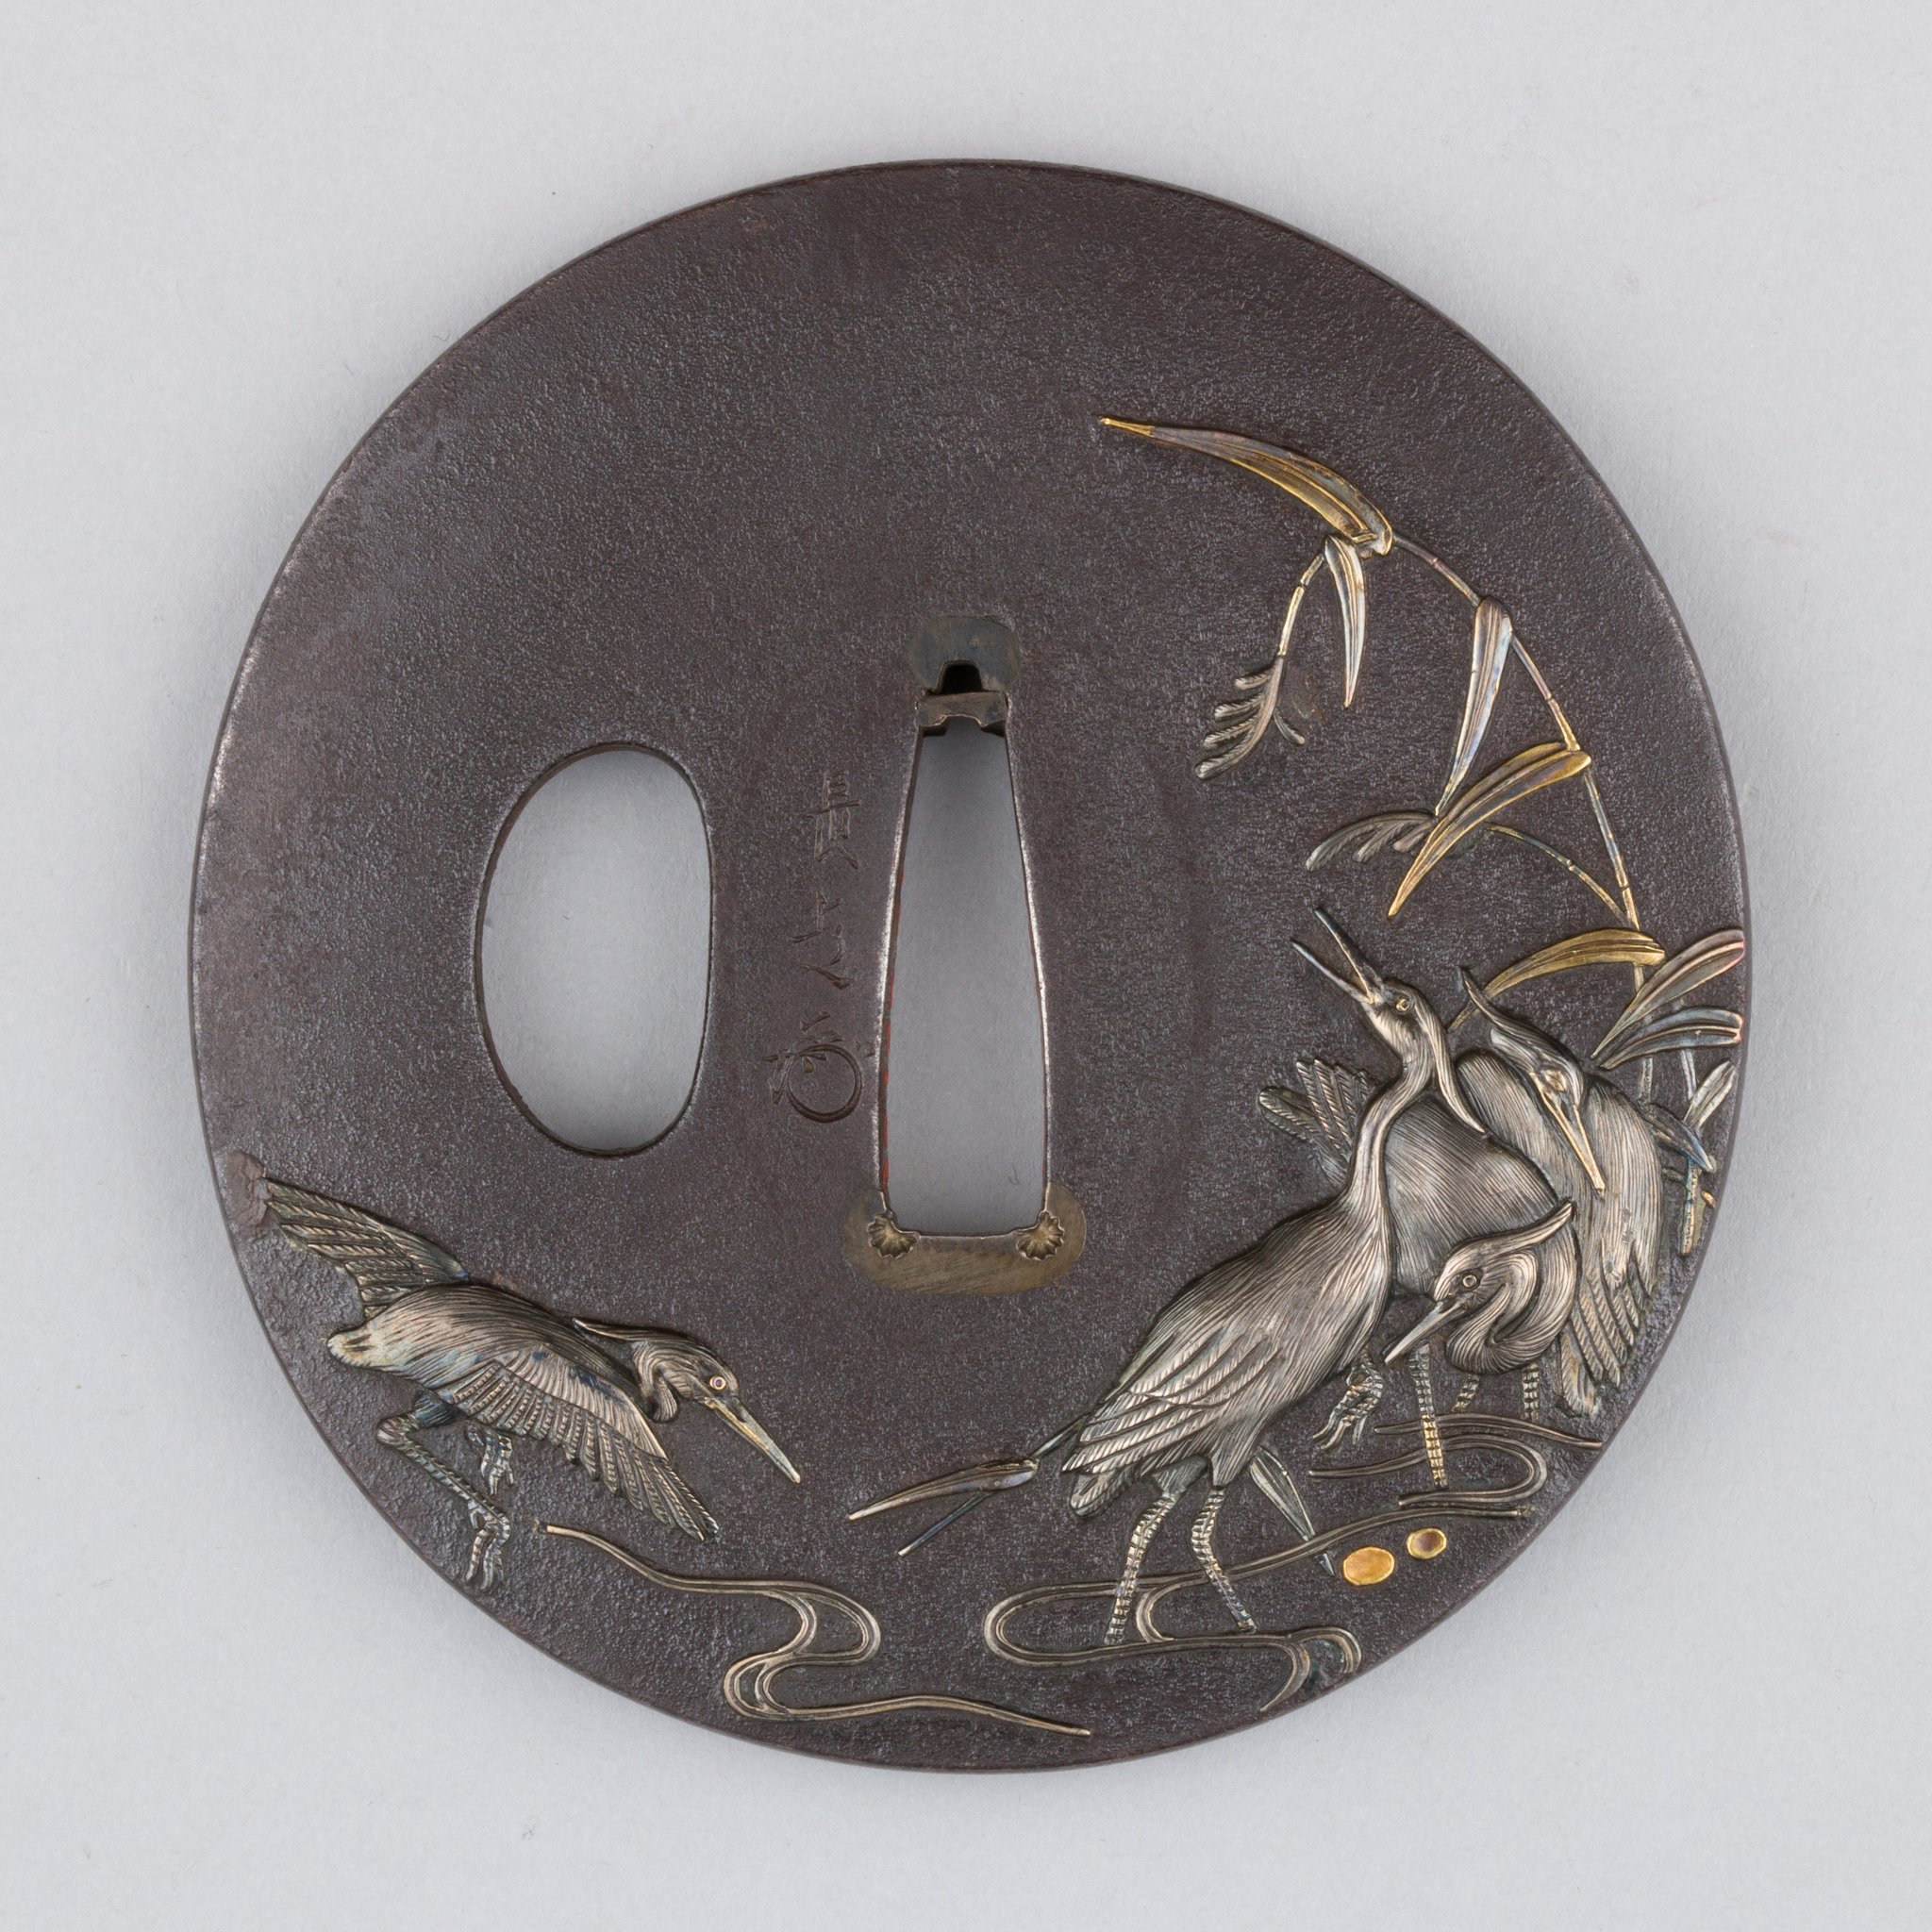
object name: sword guard tsuba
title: Sword Guard (Tsuba)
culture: japanese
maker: ichinomiya nagatsune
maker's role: fittings maker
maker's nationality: japanese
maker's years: 1721-1786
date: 1701-1800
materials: iron, silver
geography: japan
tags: cranes,plants